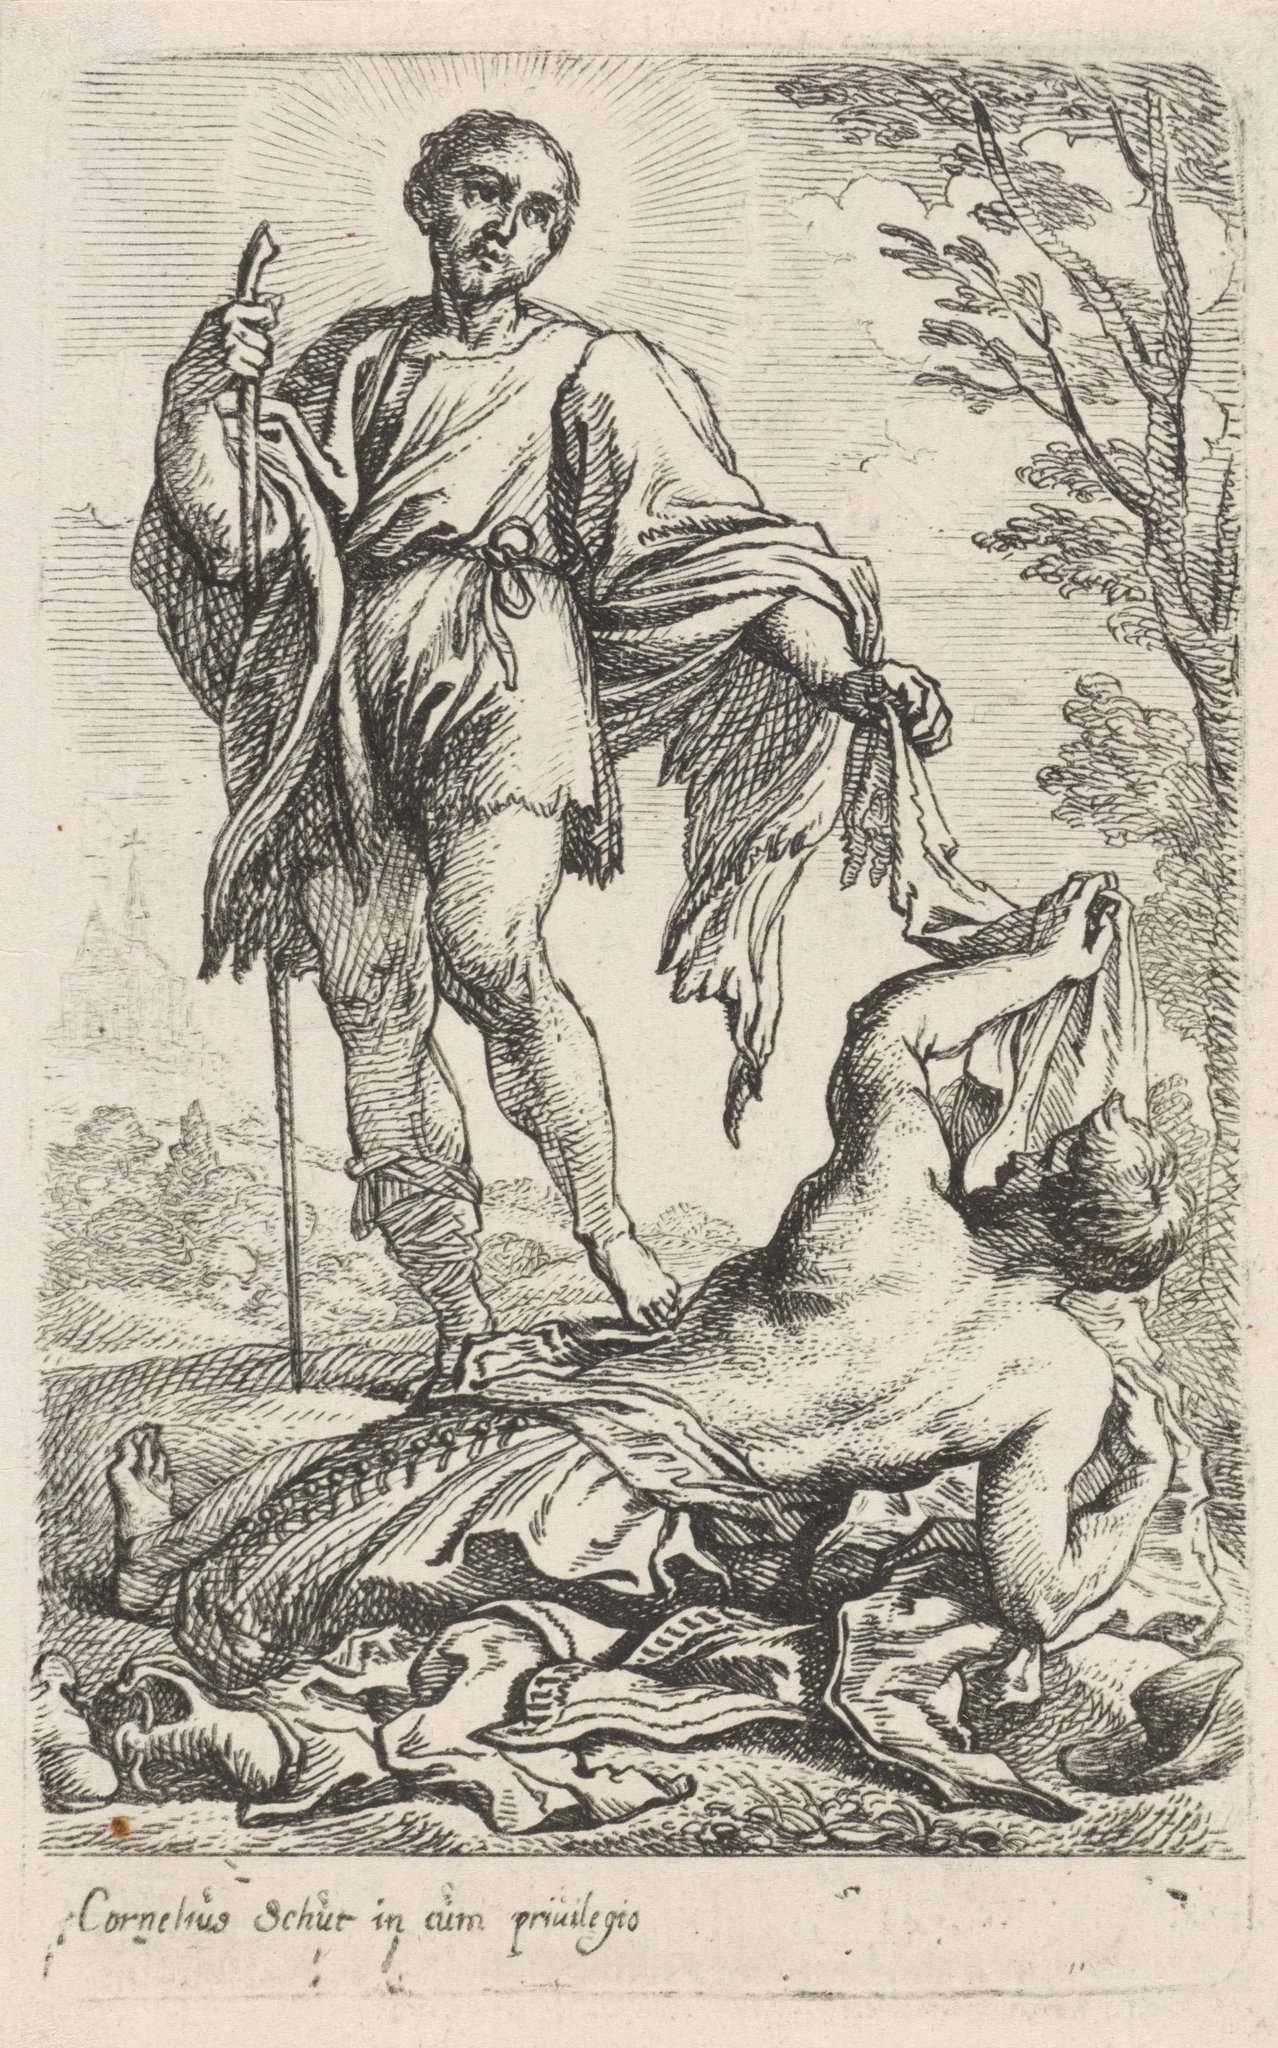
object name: print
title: H. Martinus van Tours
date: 1618-1655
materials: paper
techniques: etching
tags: martin(us), bishop of tours; possible attributes: beggar, goose - specific aspects ~ male saint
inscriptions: collector's mark: Lugt 240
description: De heilige Martinus geeft de helft van zijn door hem in tweeën gesneden mantel aan de bedelaar die op de grond ligt. Martinus is blootvoets.